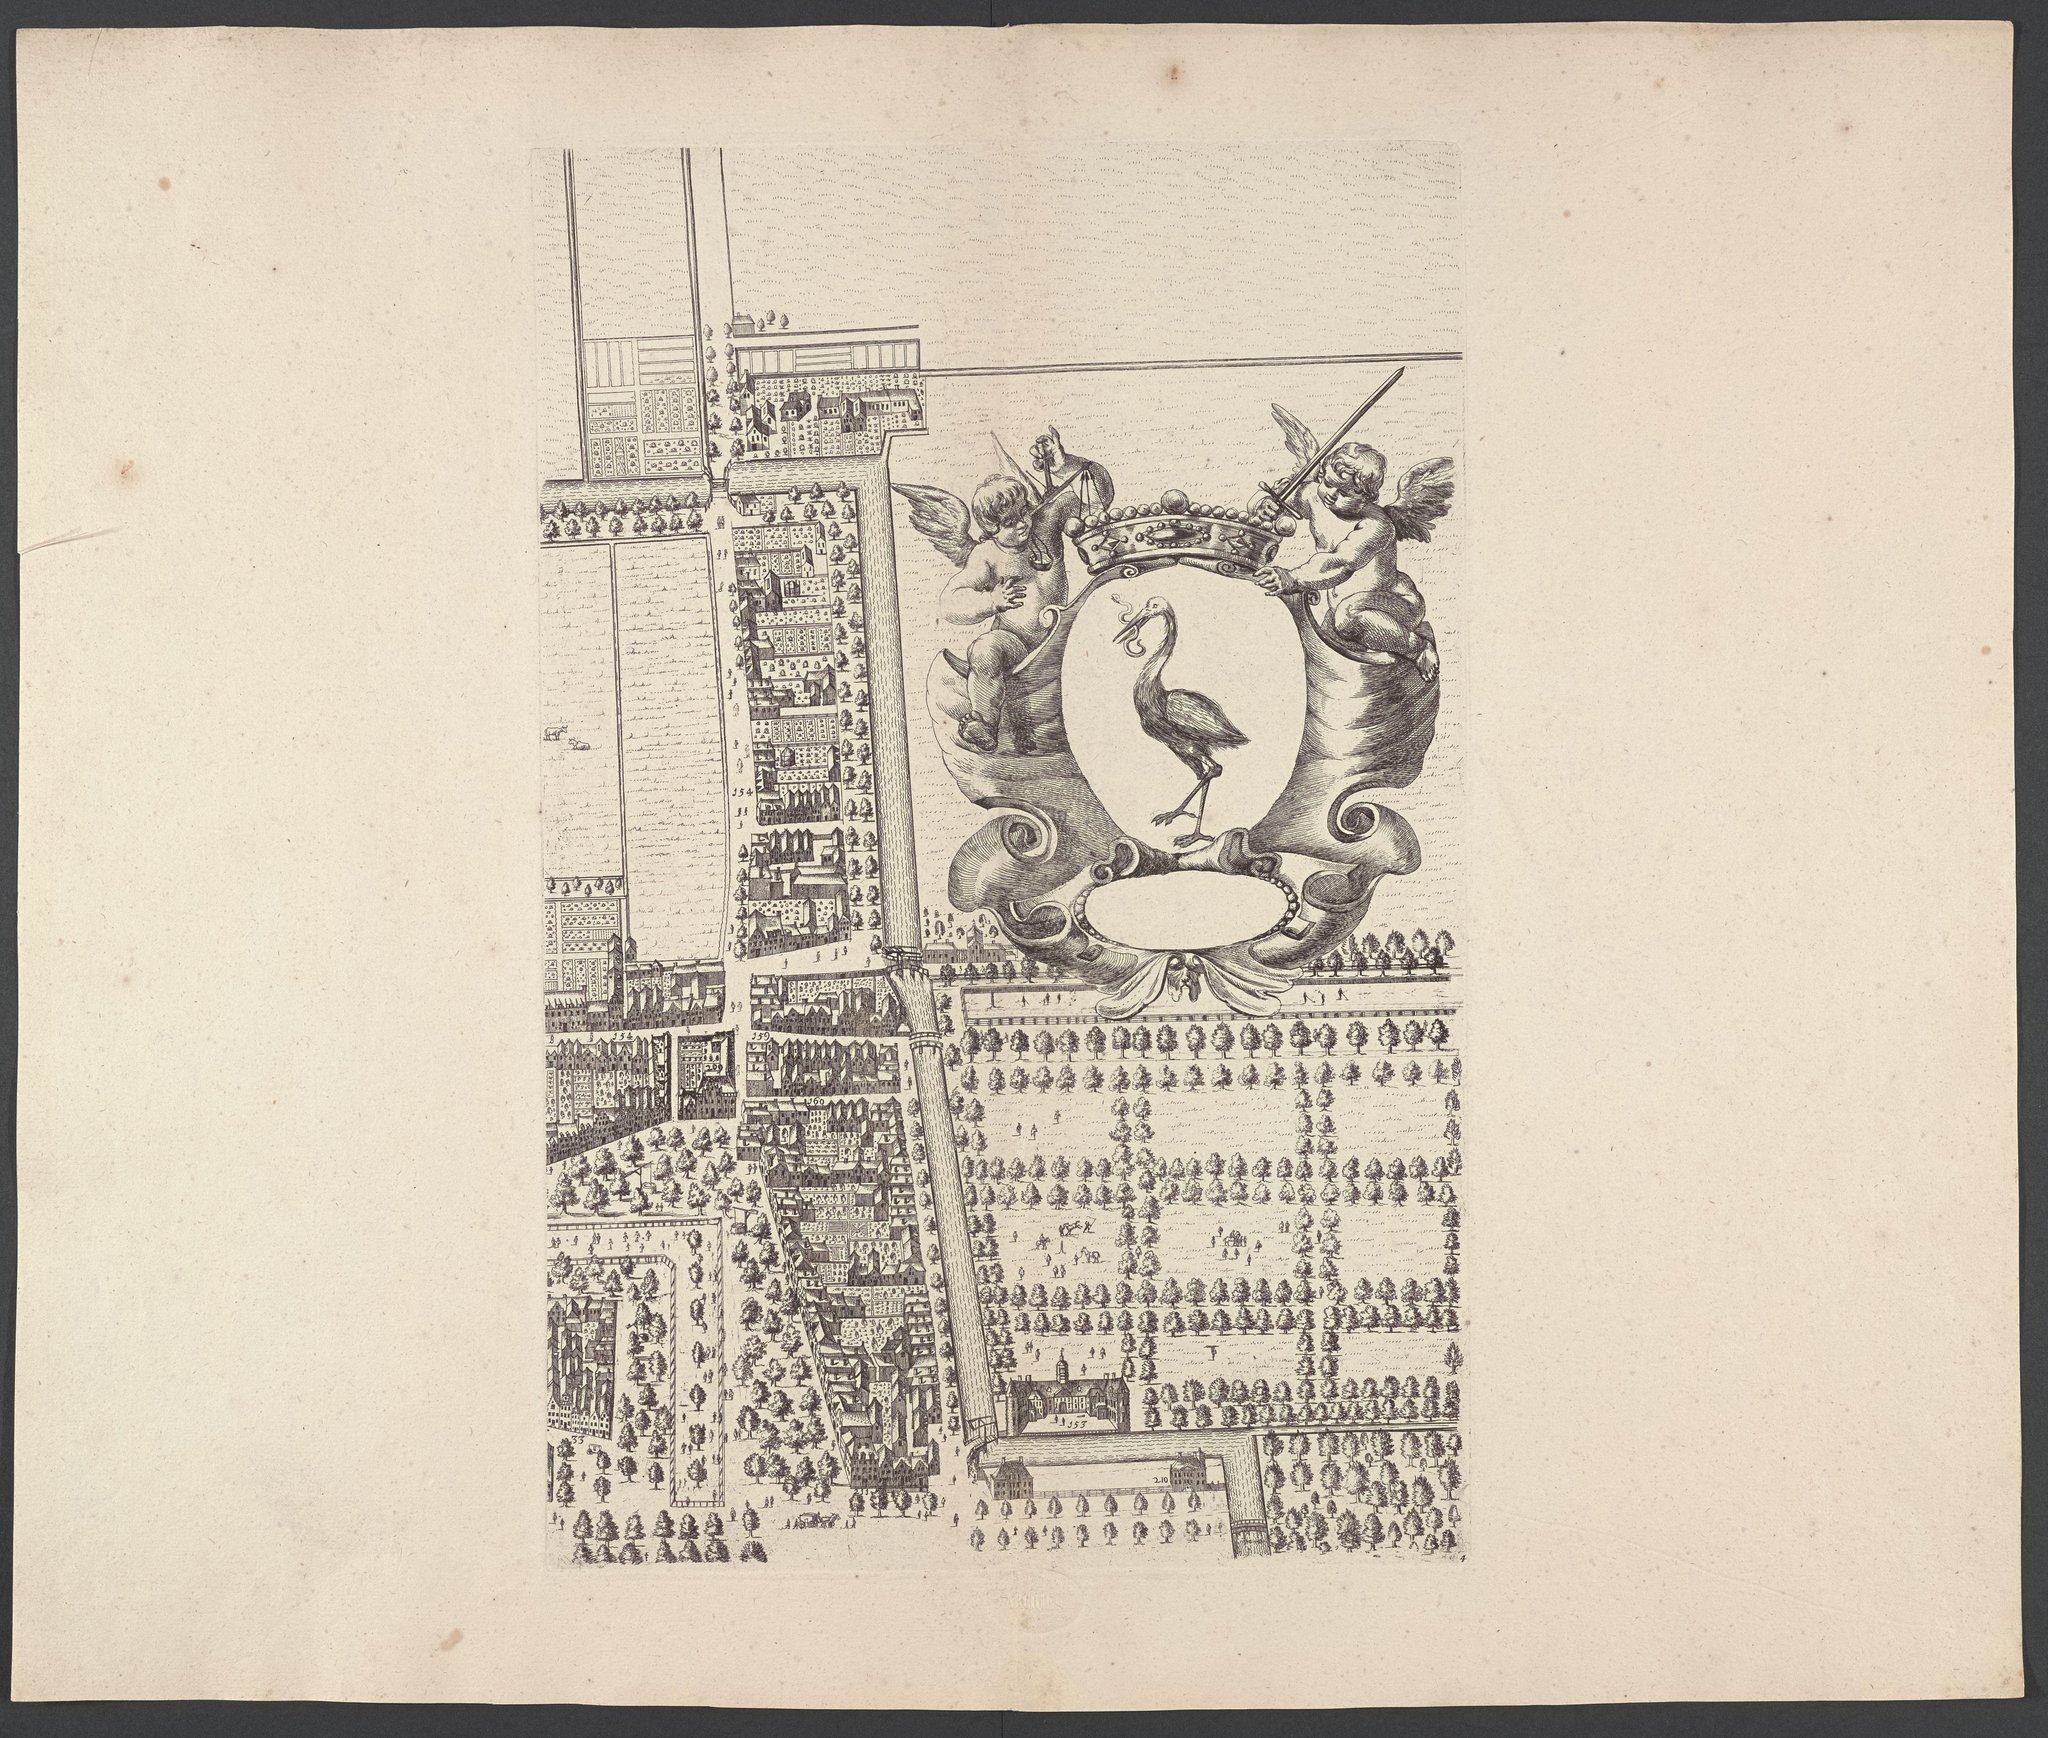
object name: print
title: Plattegrond van de figuratieve kaart van Den Haag (vierde deel)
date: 1665-1667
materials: paper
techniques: etching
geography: the hague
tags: maps of cities, the hague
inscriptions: collector's mark: Lugt 2228, check stamp: ‘Archief Ministerie van Oorlog Afdeeling Genie’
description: Deze prent is onderdeel van een plattegrond van Den Haag. Deze staat van de plattegrond werd oorspronkelijk uitgegeven met een sierrand, bestaande uit een gezicht op de stad en veertien kleinere gezichten in en om Den Haag, en vormde zo de zogenaamde figuratieve kaart van Den Haag. Voor de prenten die de rand vormen, zie: RP-P-AO-12-8, RP-P-AO-12-8-2, RP-P-OB-50.201, RP-P-OB-50.202, RP-P-OB-50.203, RP-P-OB-50.204, RP-P-OB-50.205, RP-P-OB-50.206, RP-P-OB-50.207, RP-P-OB-50.208, RP-P-OB-102.387, RP-P-OB-50.209, RP-P-OB-50.210, RP-P-OB-50.211, RP-P-OB-50.212, RP-P-OB-50.213, RP-P-AO-12-5-4 en RP-P-OB-50.214.